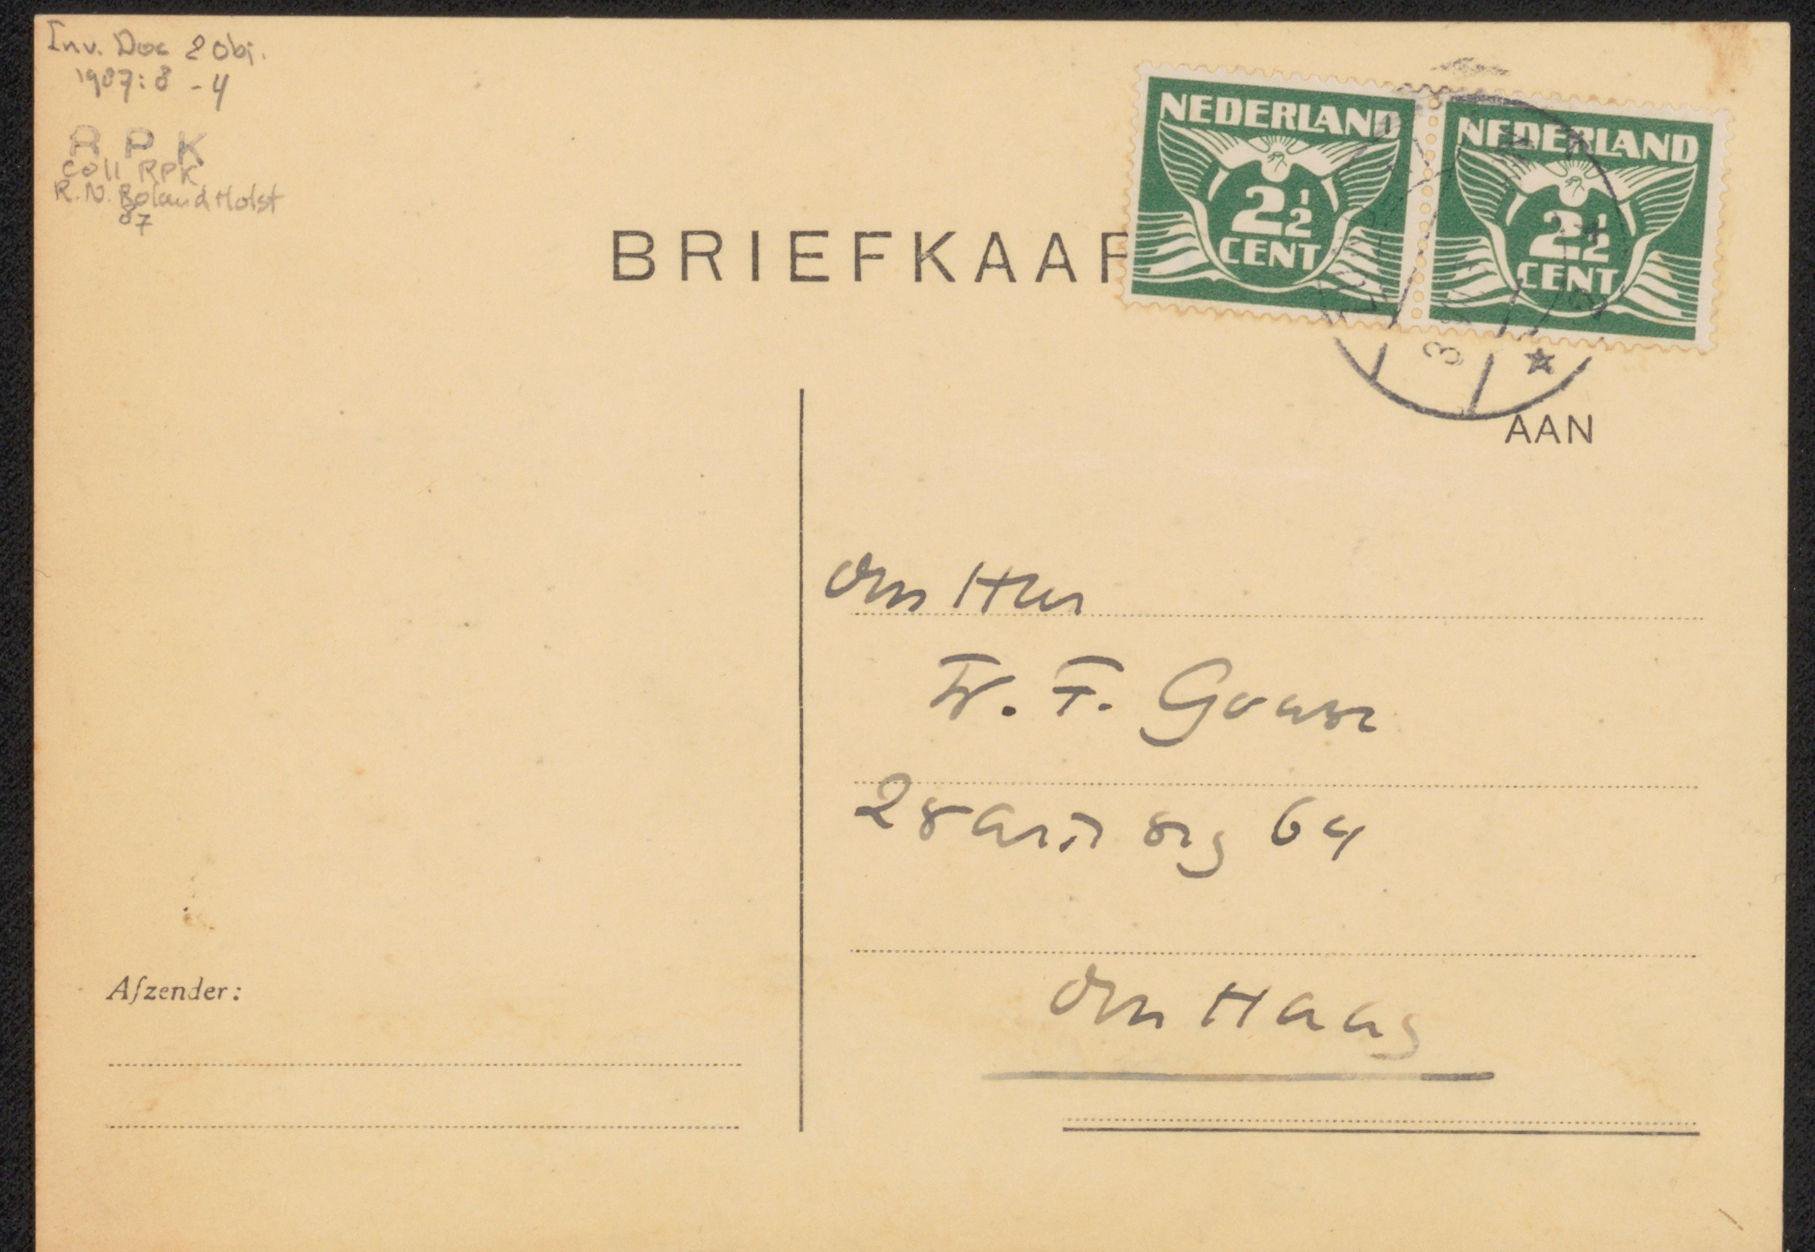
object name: postcard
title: Briefkaart aan Willem Frederik Gouwe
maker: richard nicolaüs roland holst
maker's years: 1868-1938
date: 1936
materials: cardboard, ink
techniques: pen, writing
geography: zundert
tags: the hague, amsterdam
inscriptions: collector's mark: ‘RPK’